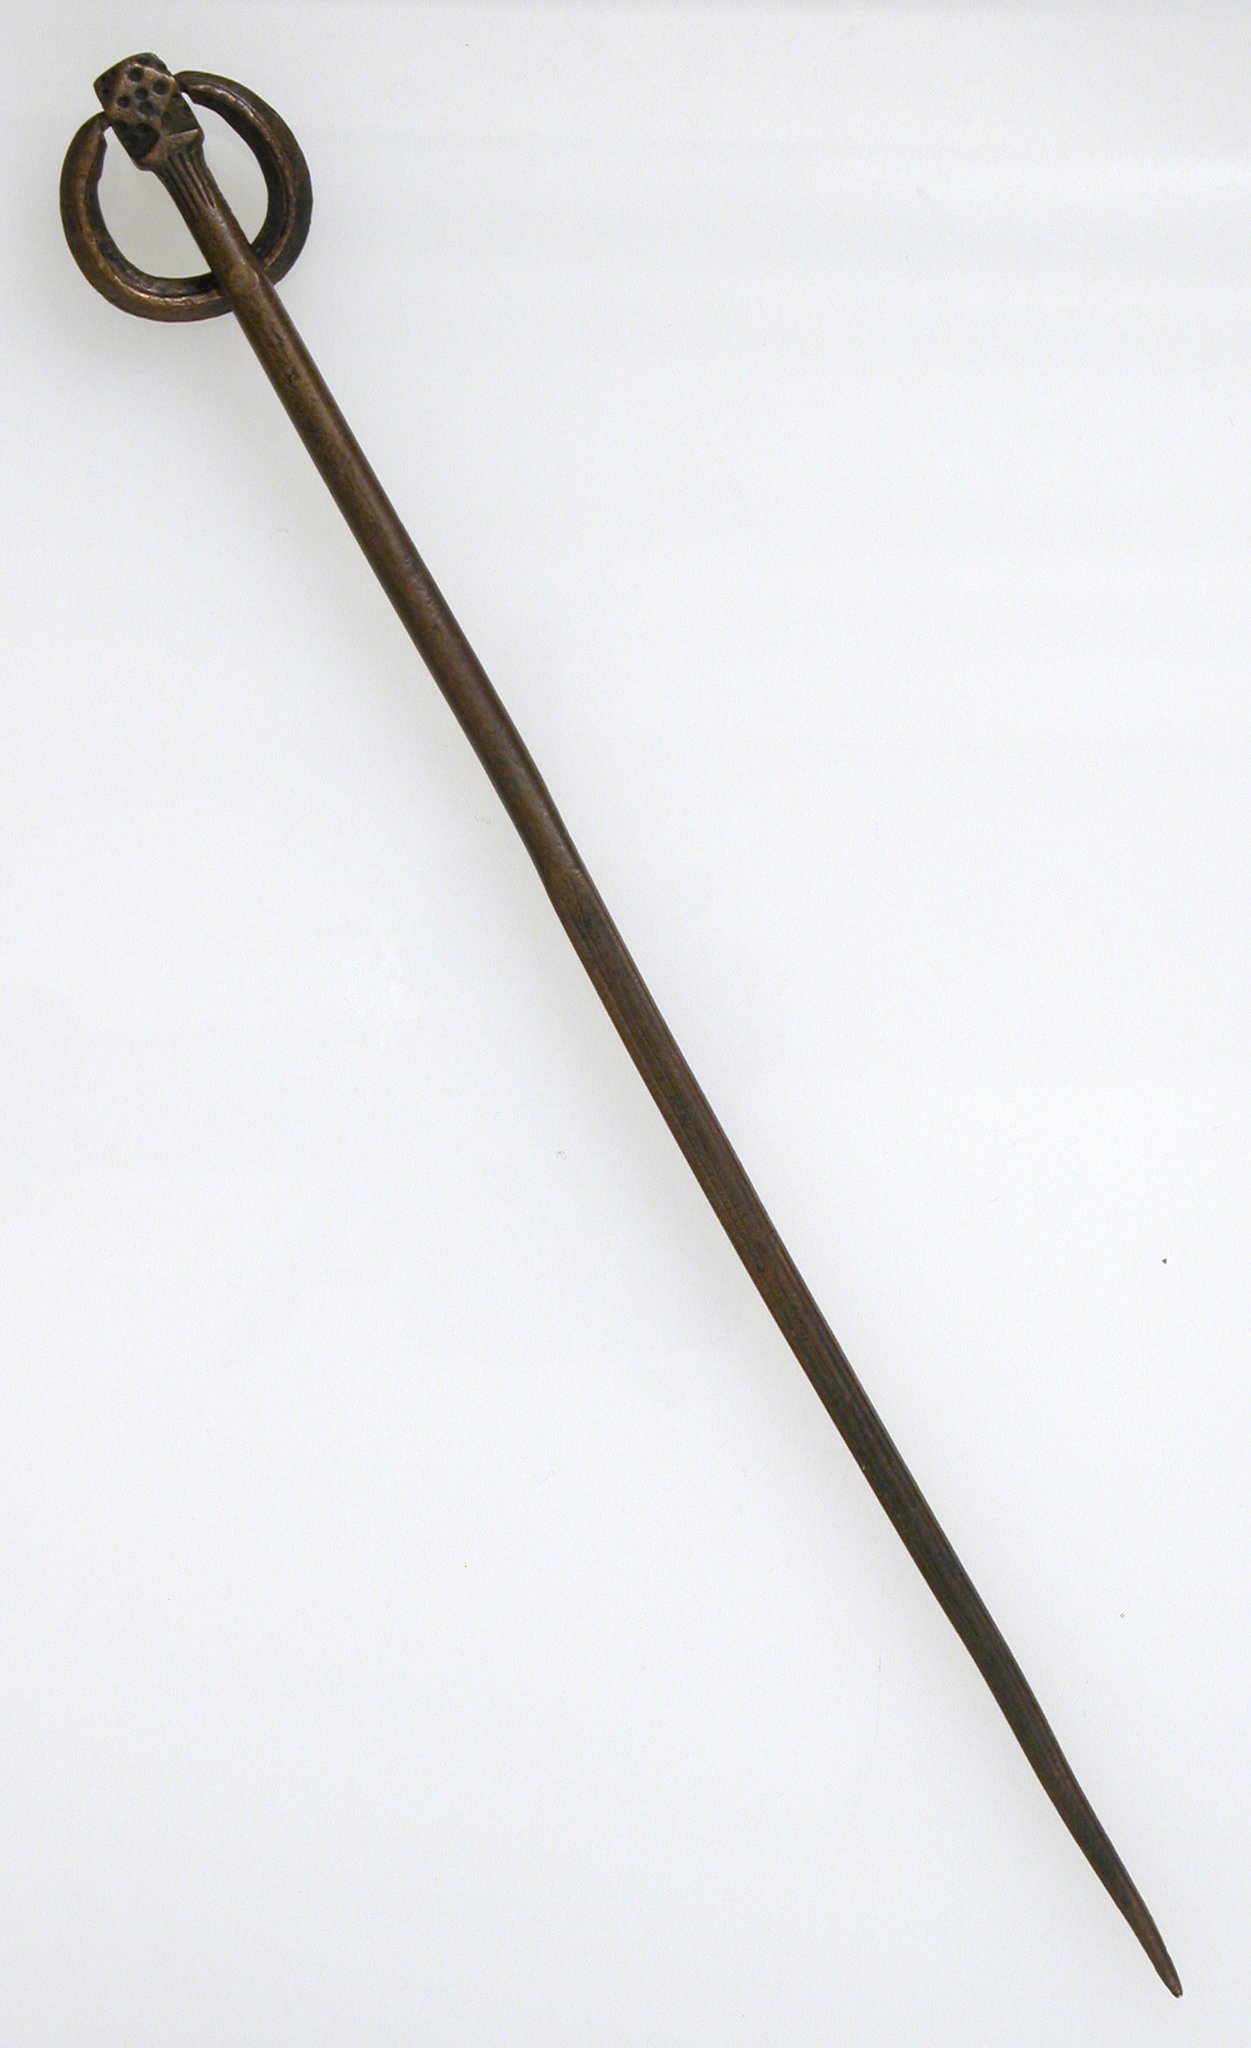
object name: brooch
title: Annular Brooch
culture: irish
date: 801-900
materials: copper alloy